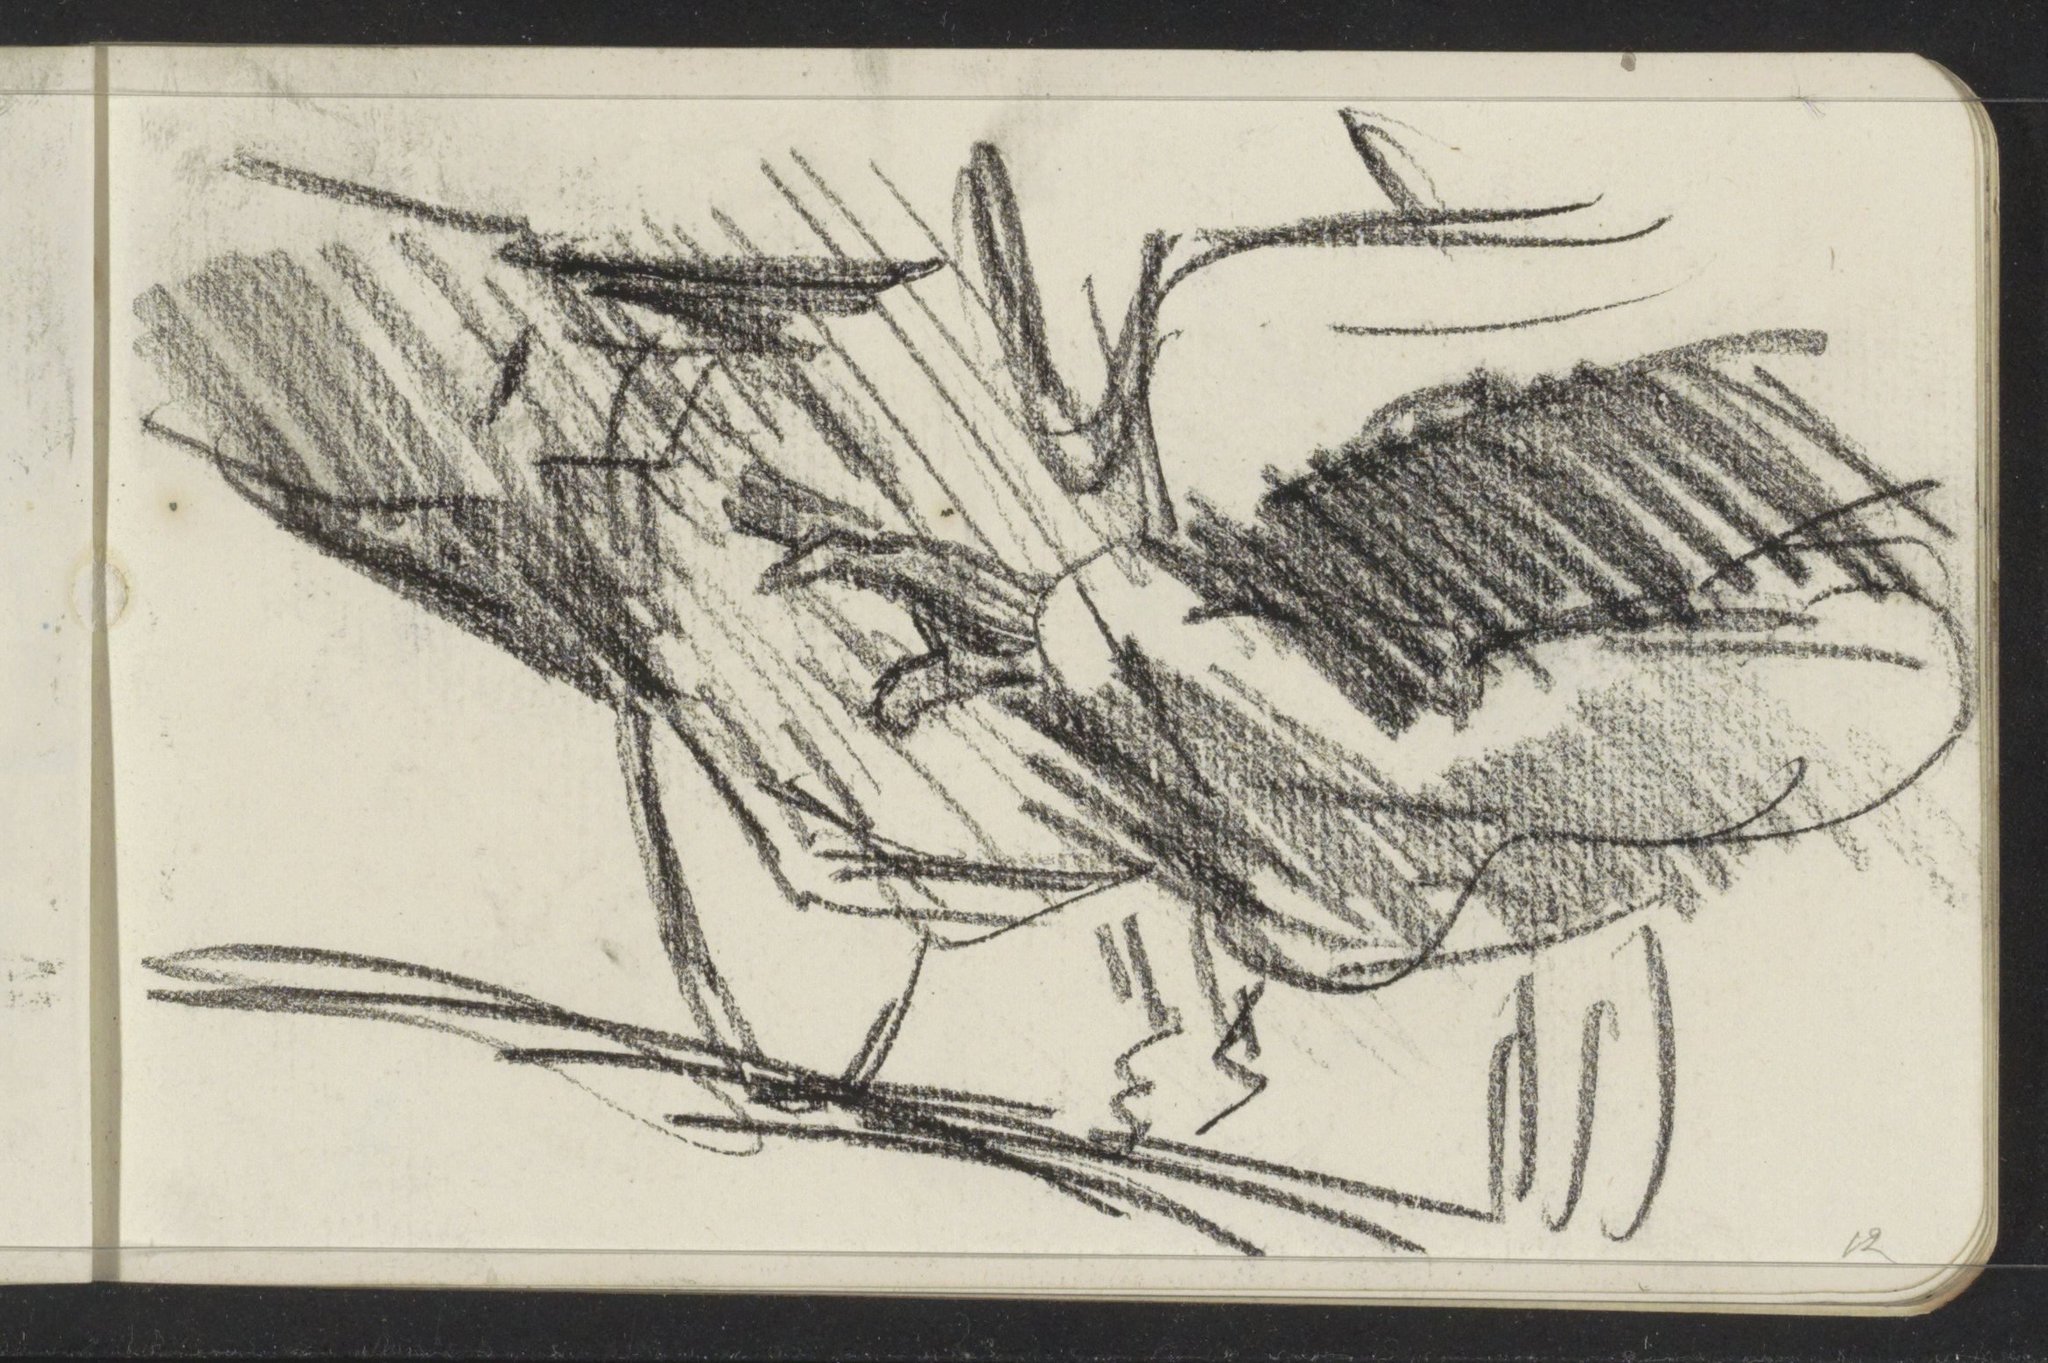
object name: sketchbook leaf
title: Figuur op een stoel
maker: isaac israels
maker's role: draughtsman, painter, print maker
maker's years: 1865-1934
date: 1875-1934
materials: chalk, paper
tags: sitting figure, chair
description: Blad 12 recto uit schetsboek LXII met 28 bladen.